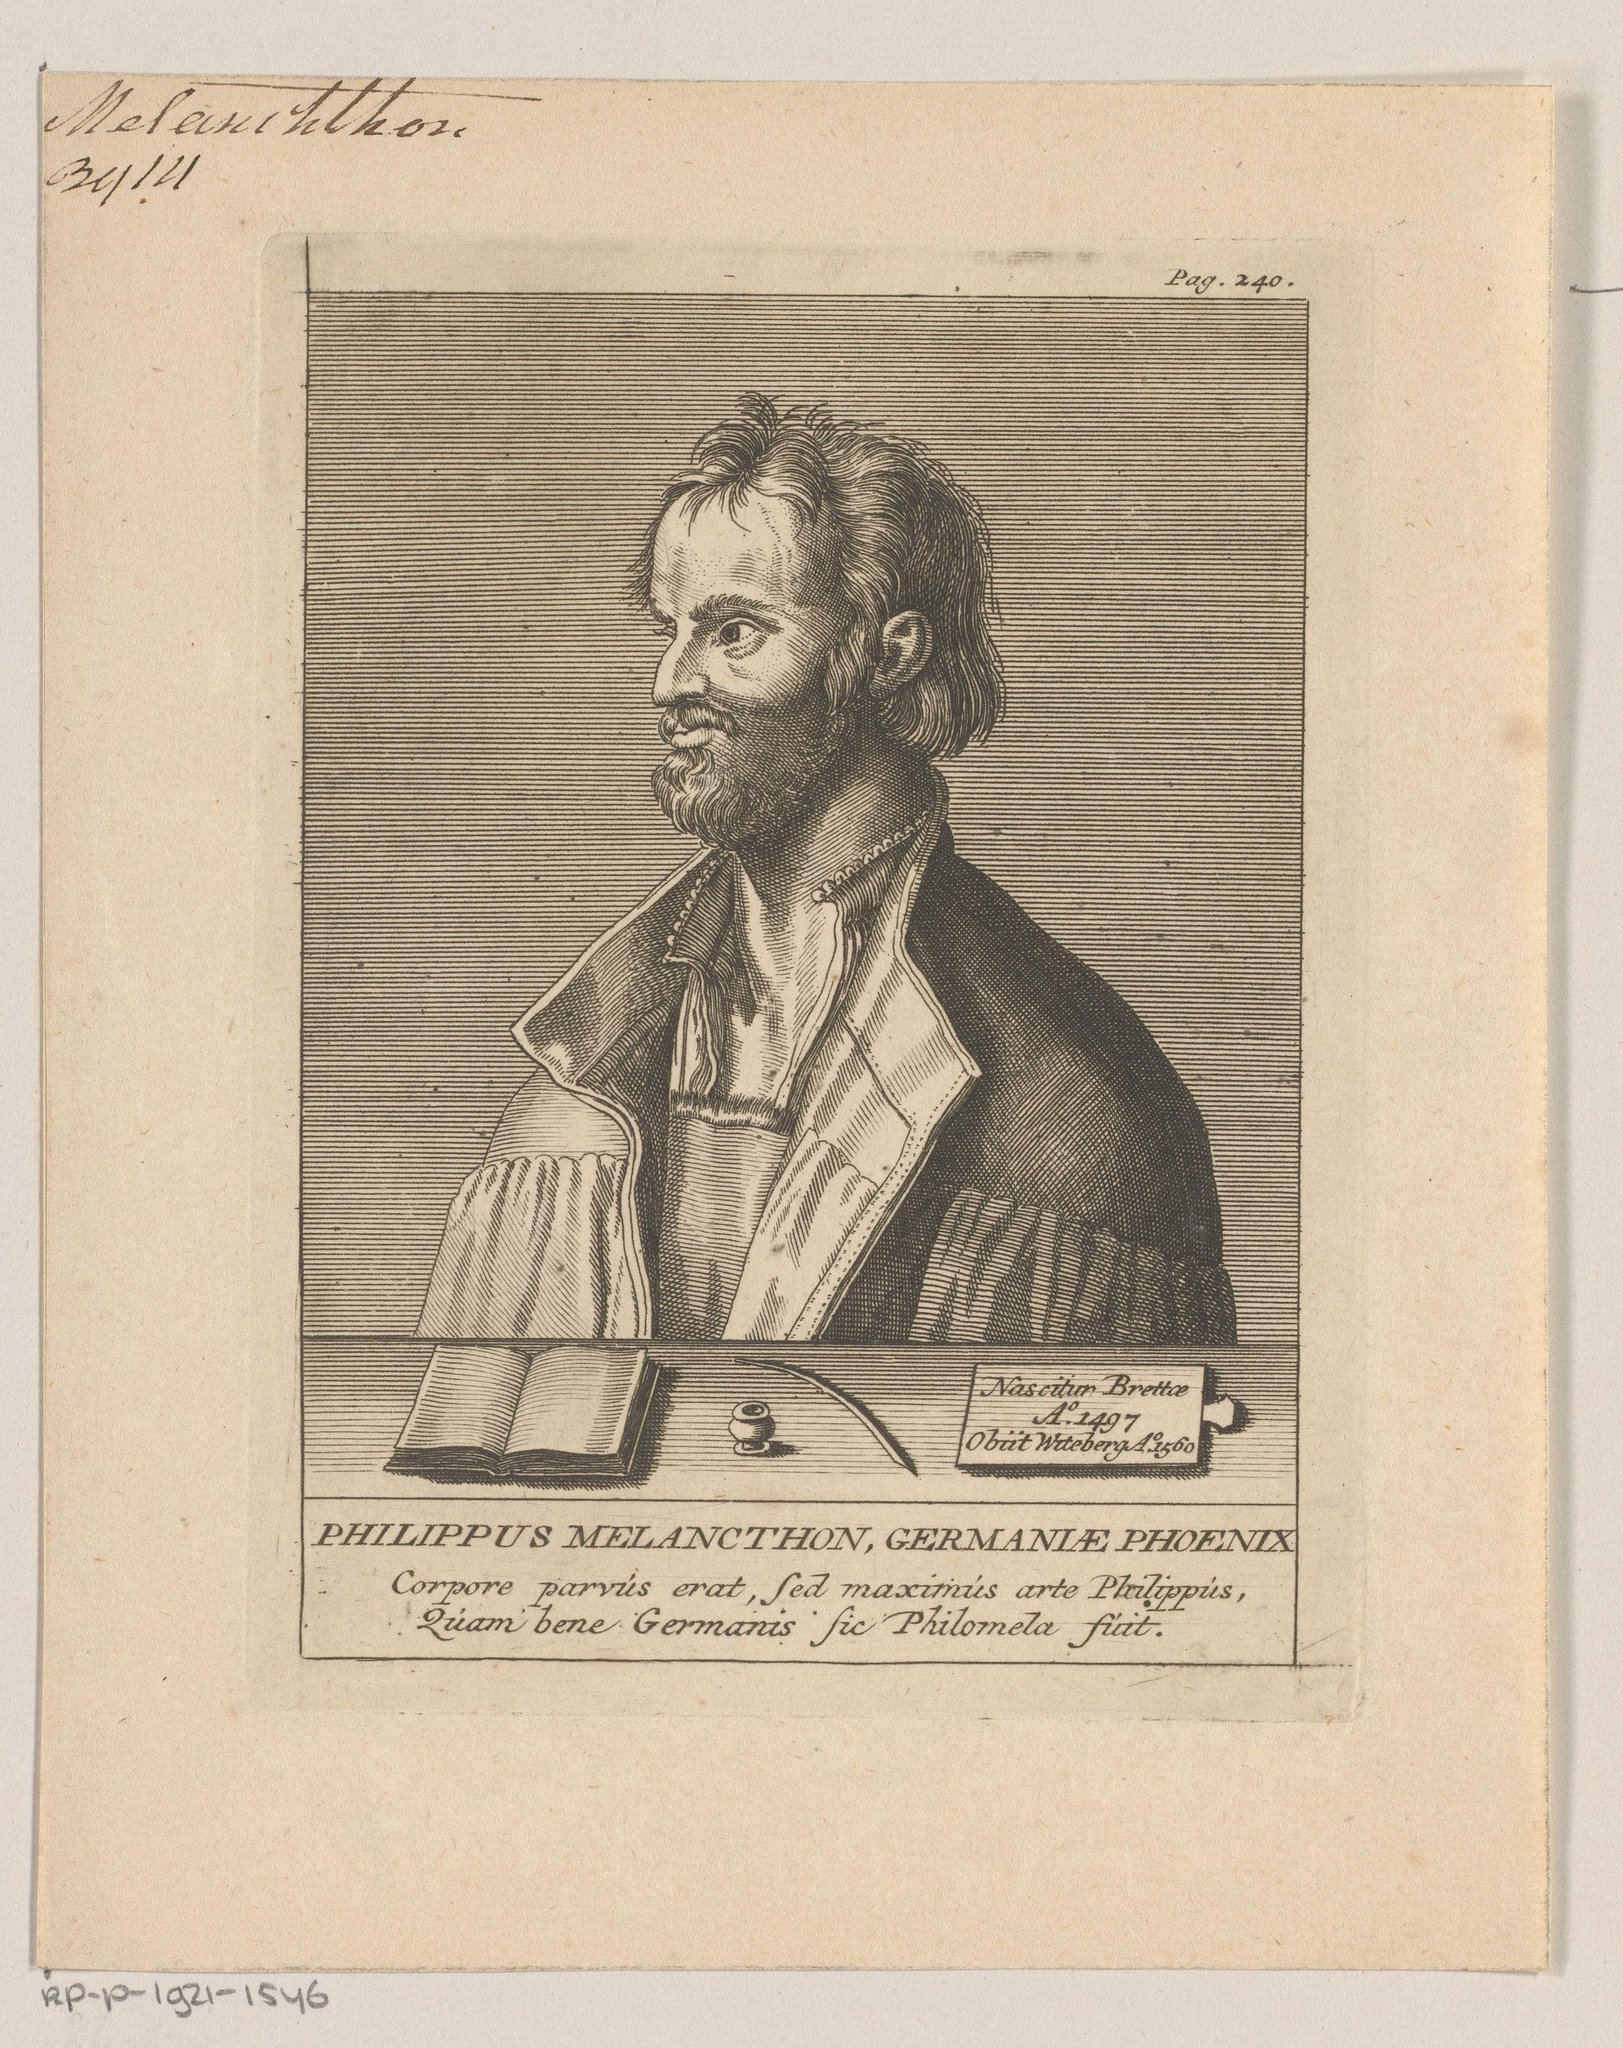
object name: print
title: Portret van Philipp Melanchthon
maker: Anonymous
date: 1600-1800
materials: paper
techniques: engraving, etching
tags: theologian, historical persons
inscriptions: collector's mark: Lugt 2233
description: Met tweeregelig onderschrift in het Latijn. Rechtsboven: Pag. 240.